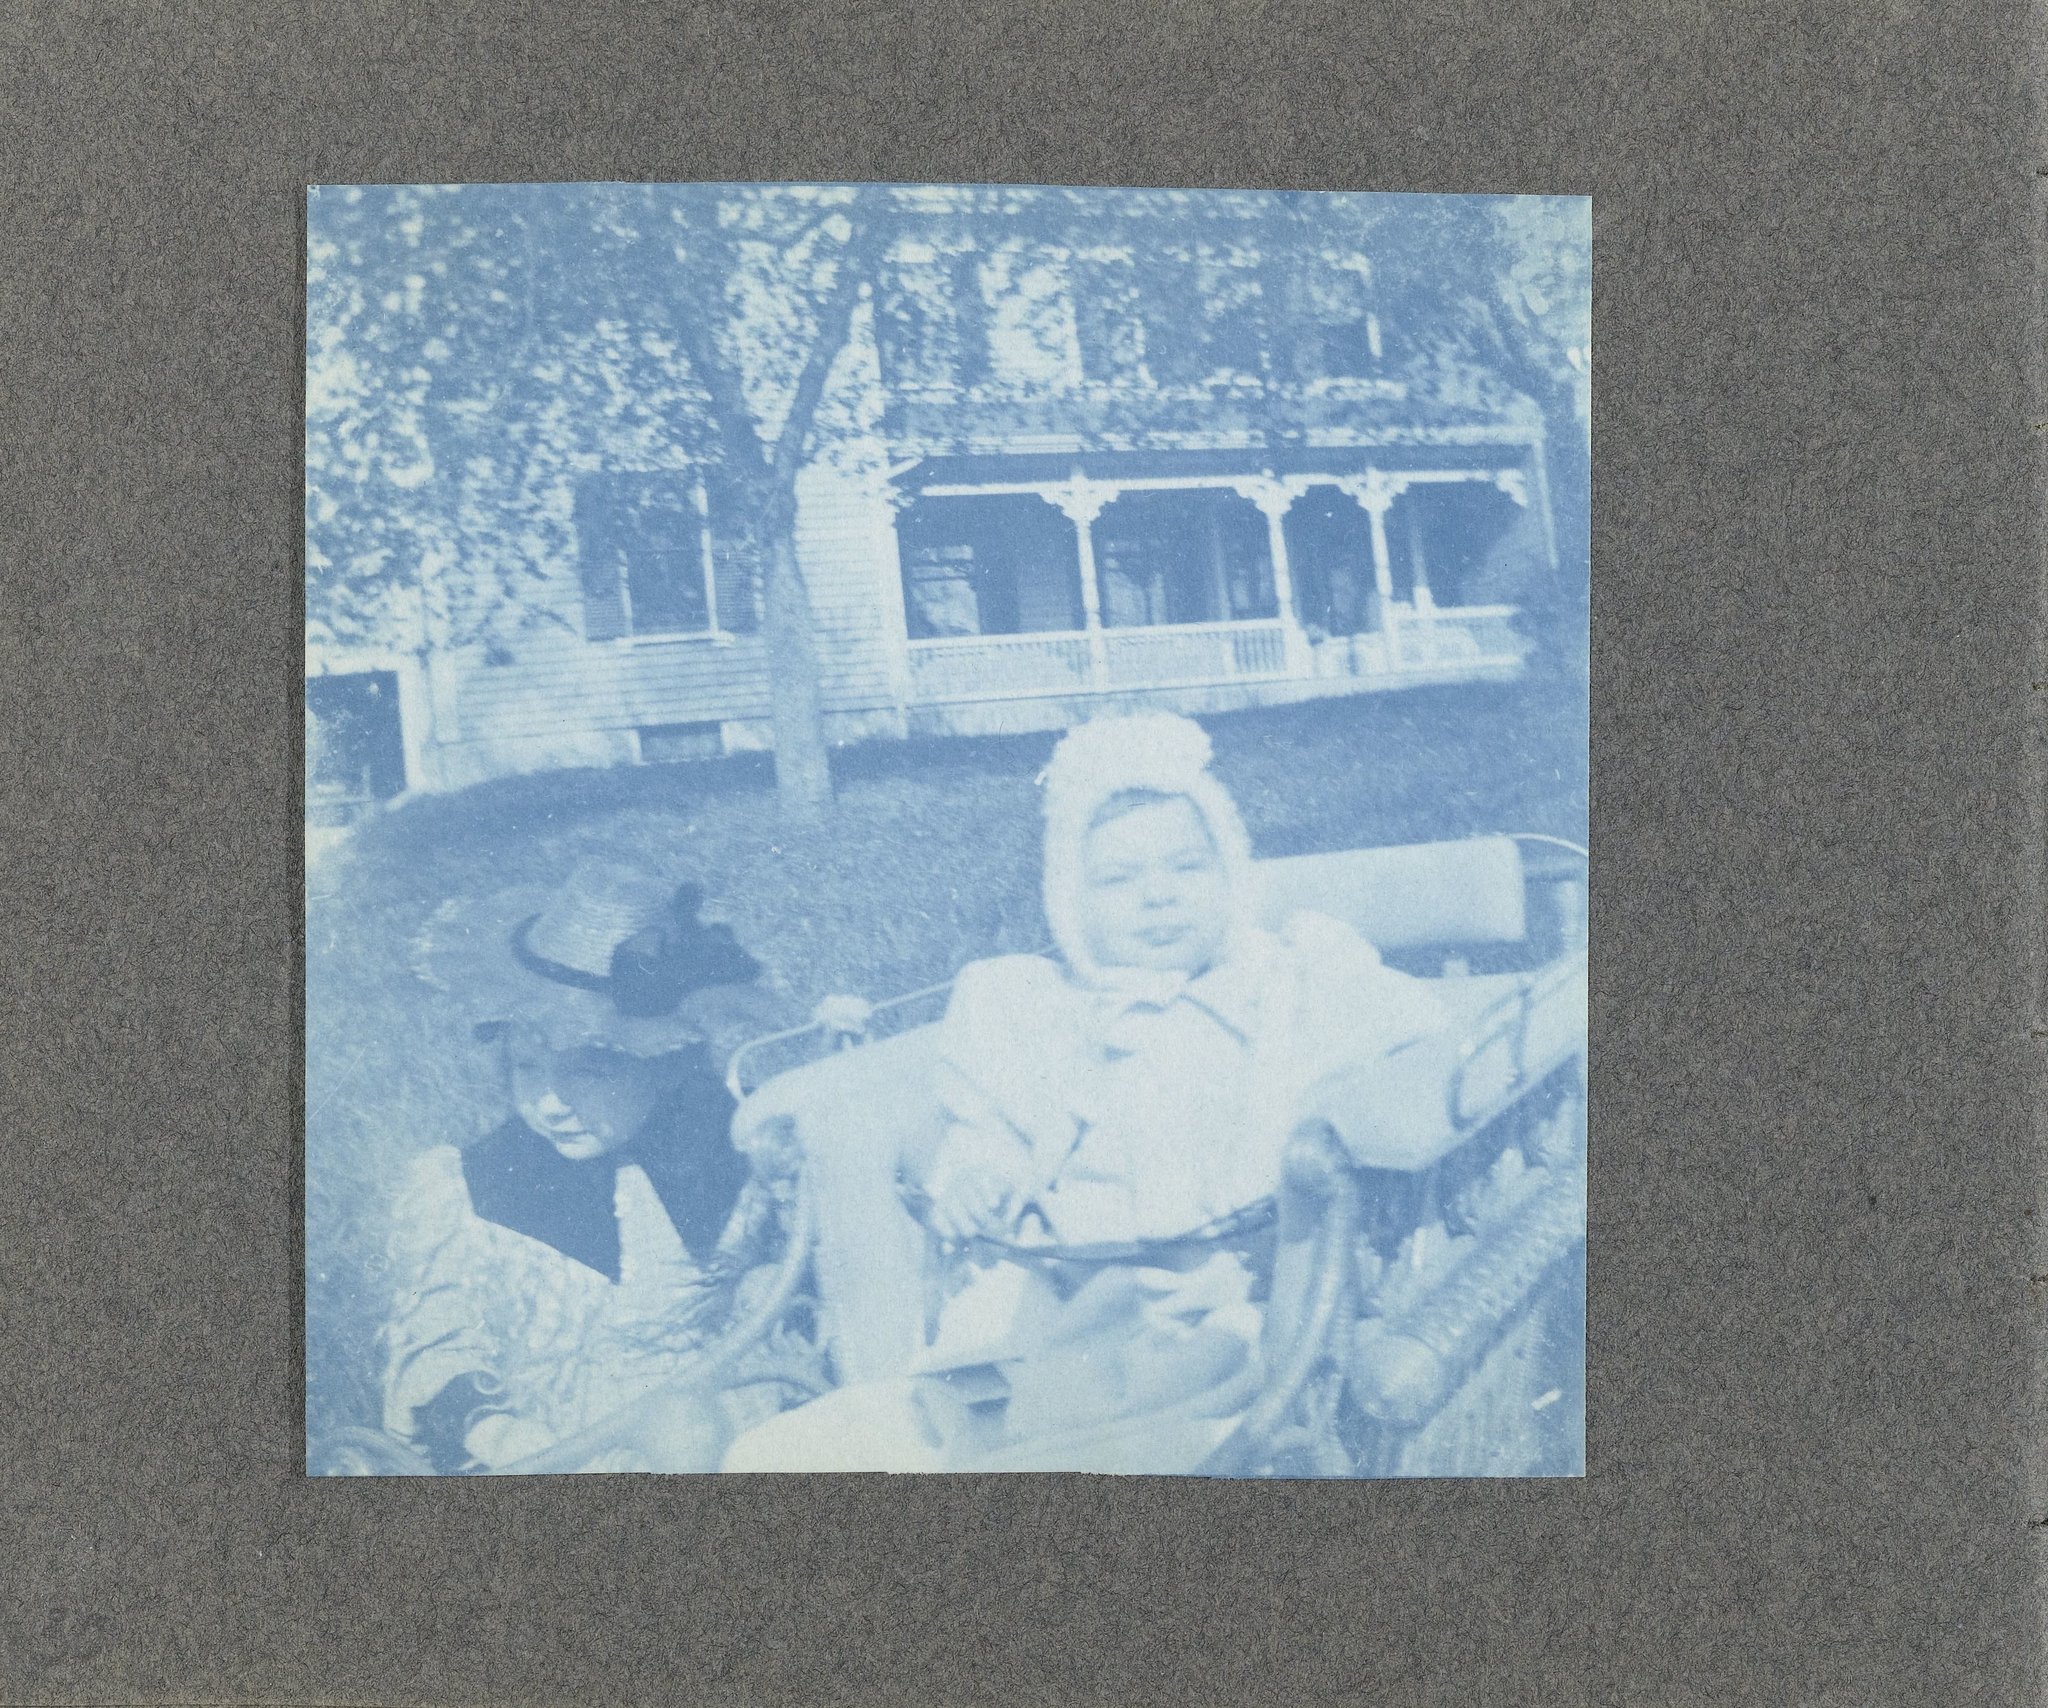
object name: photograph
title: Twee kinderen voor een houten huis, Verenigde Staten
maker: Anonymous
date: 1900-1920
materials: paper, photographic support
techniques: cyanotype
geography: united states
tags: child, historical persons, infant, baby ~ the ages of man, united states of america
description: Onderdeel van Fotoalbum met 53 cyanotypieën van kinderen, paarden, huizen, boten en strandtaferelen in de Verenigde Staten.